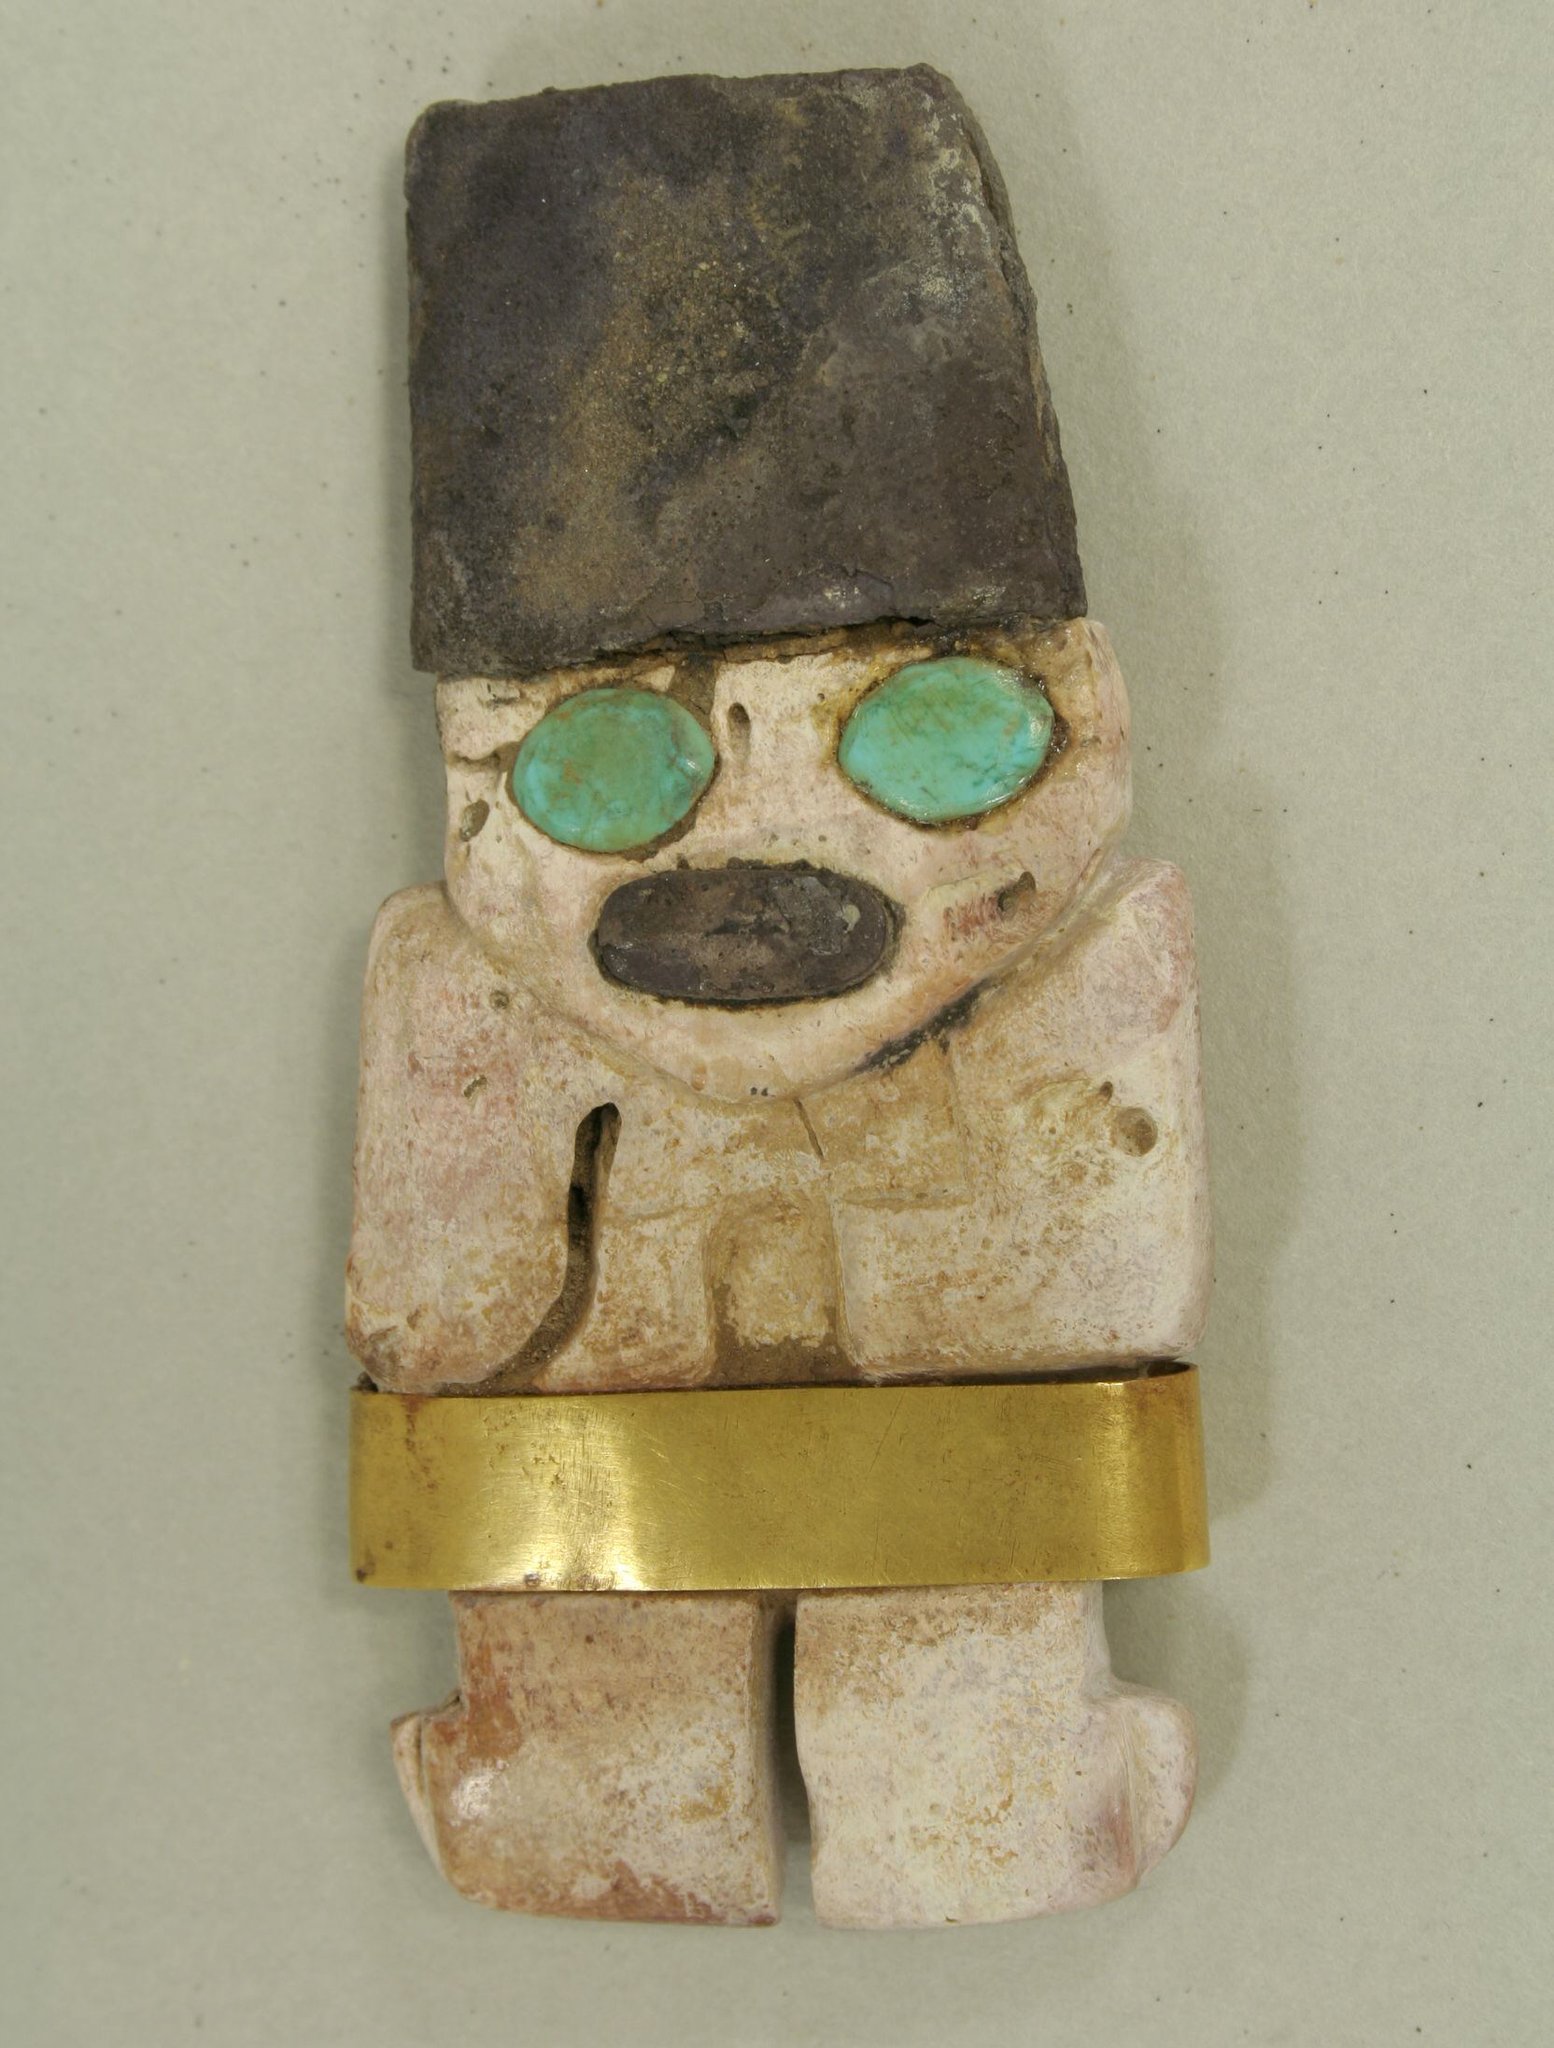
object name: figure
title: Standing Figure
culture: nasca or wari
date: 501-700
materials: gold, shell, silver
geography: peru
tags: human figures